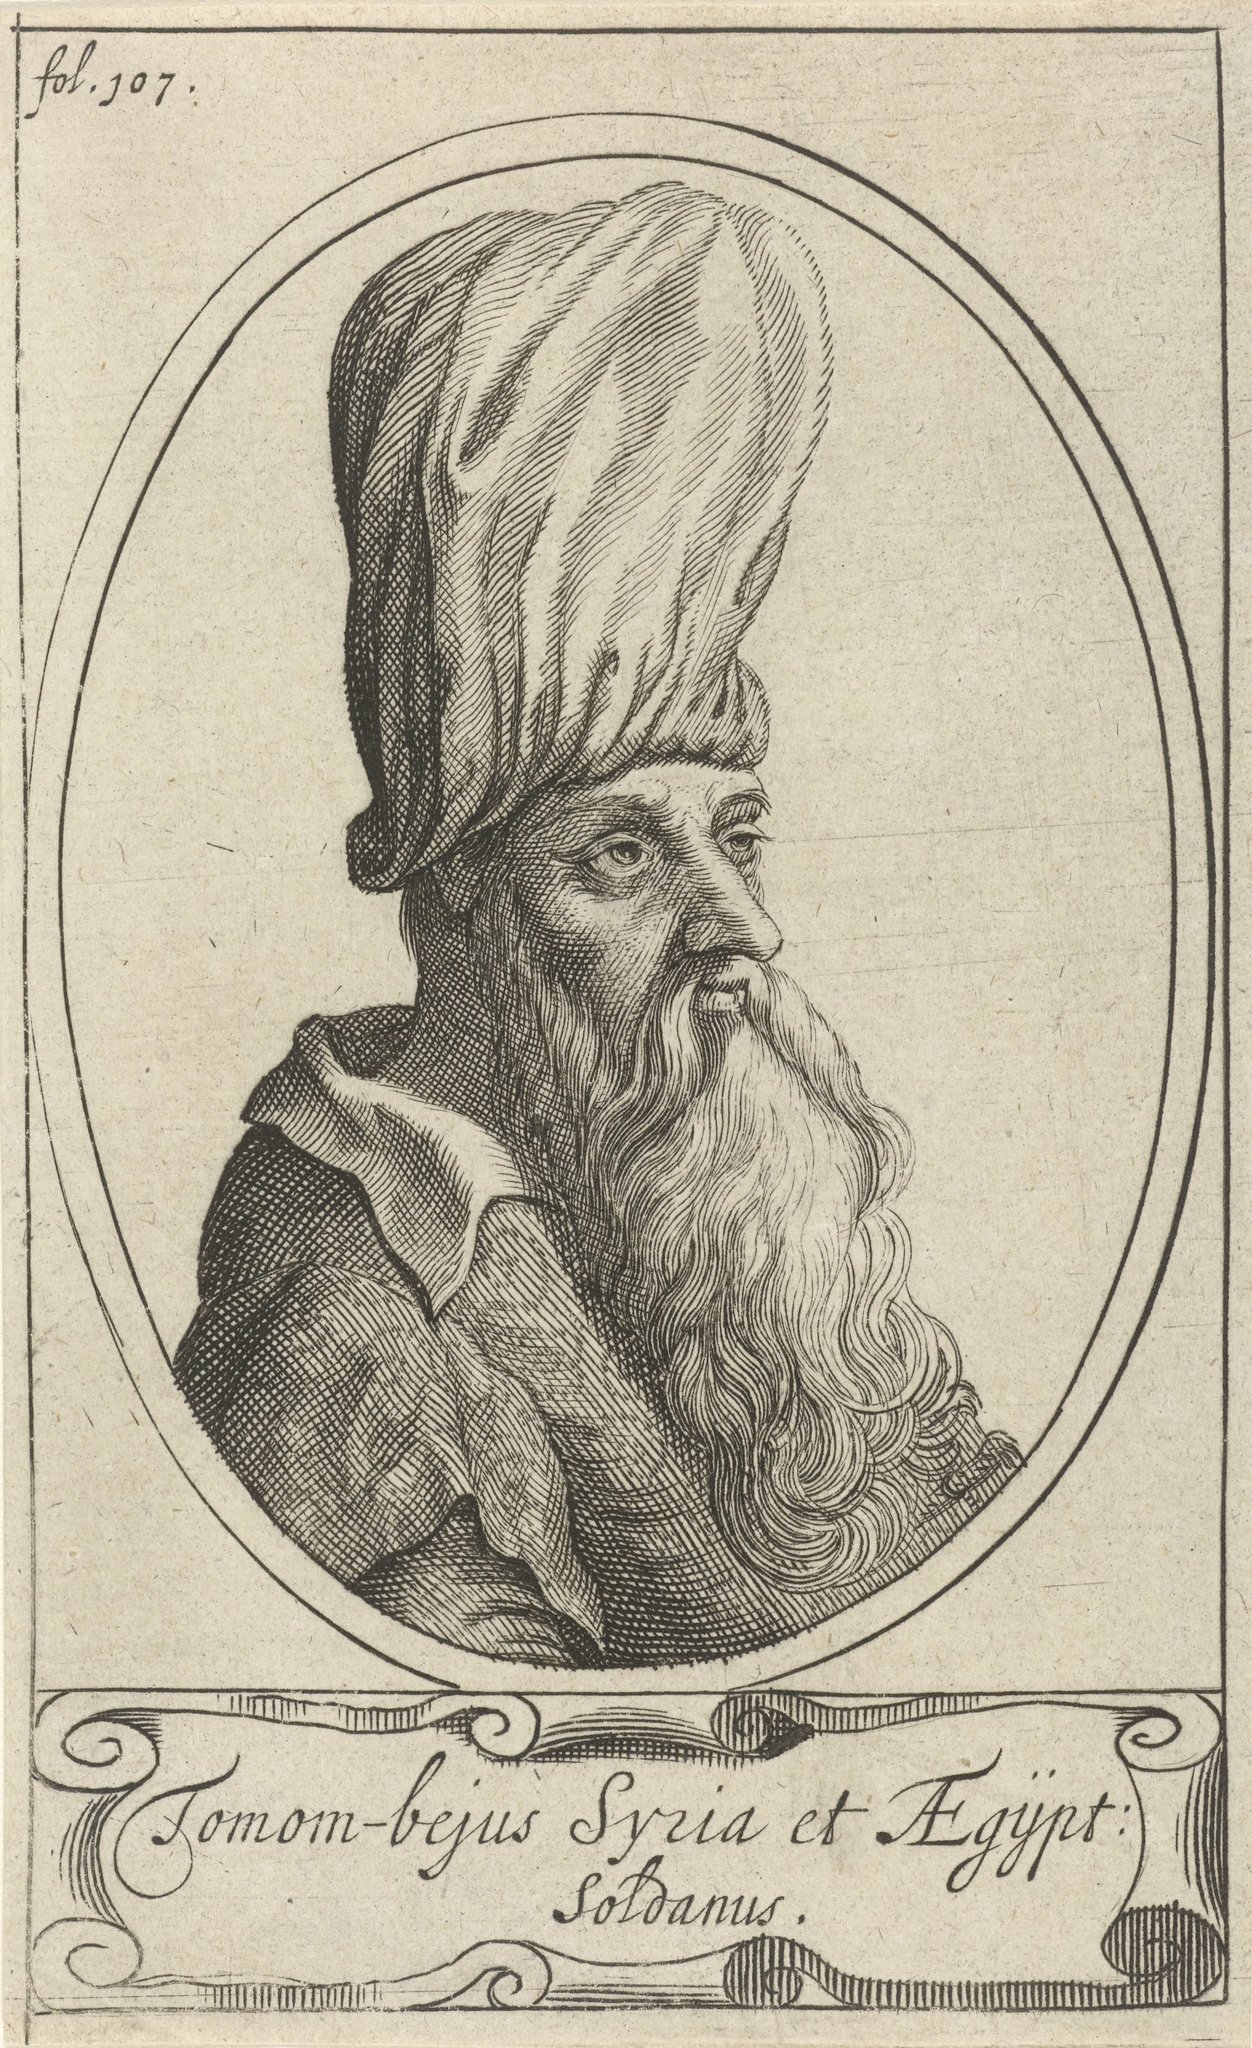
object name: print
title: Portret van een oosterse vorst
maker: theodor matham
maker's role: draughtsman, print maker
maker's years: 1605-1676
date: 1615-1676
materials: paper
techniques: engraving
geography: northern netherlands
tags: head-gear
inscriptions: collector's mark: Lugt 2228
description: Portret van een vorst van Syrië en Egypte, met hoge tulband. Linksboven: Fol. 107.